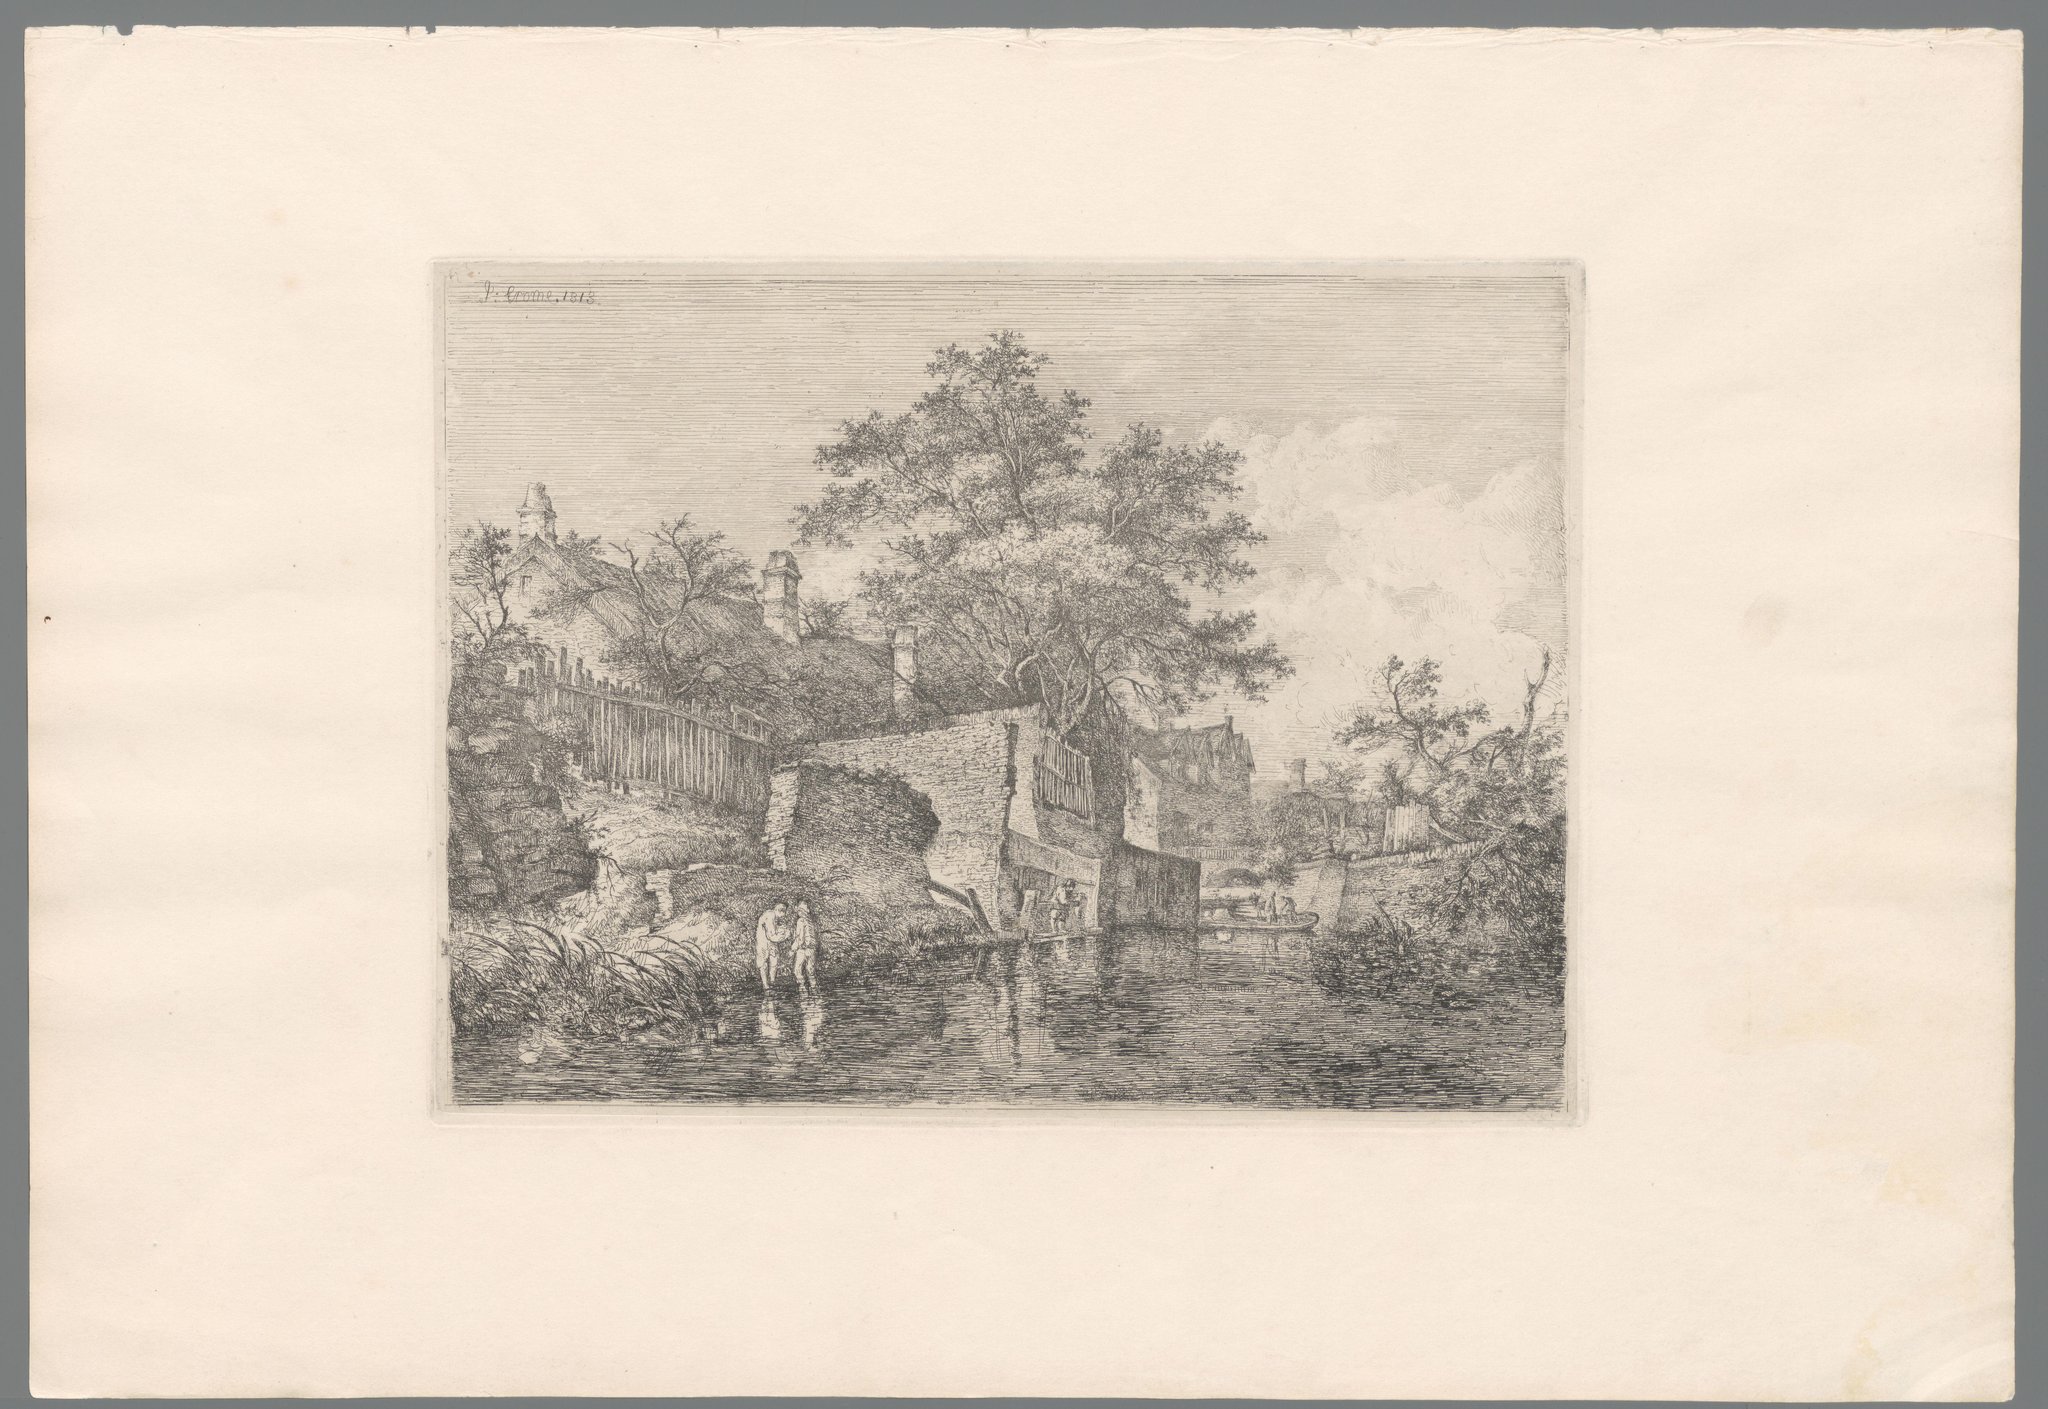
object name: print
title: Front of the New Mills, Norwich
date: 1813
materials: paper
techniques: etching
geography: norwich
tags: rowing-boat, canoe, etc., pool, puddle, watermill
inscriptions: collector's mark: Lugt 2228, collector's mark: Lugt 2760